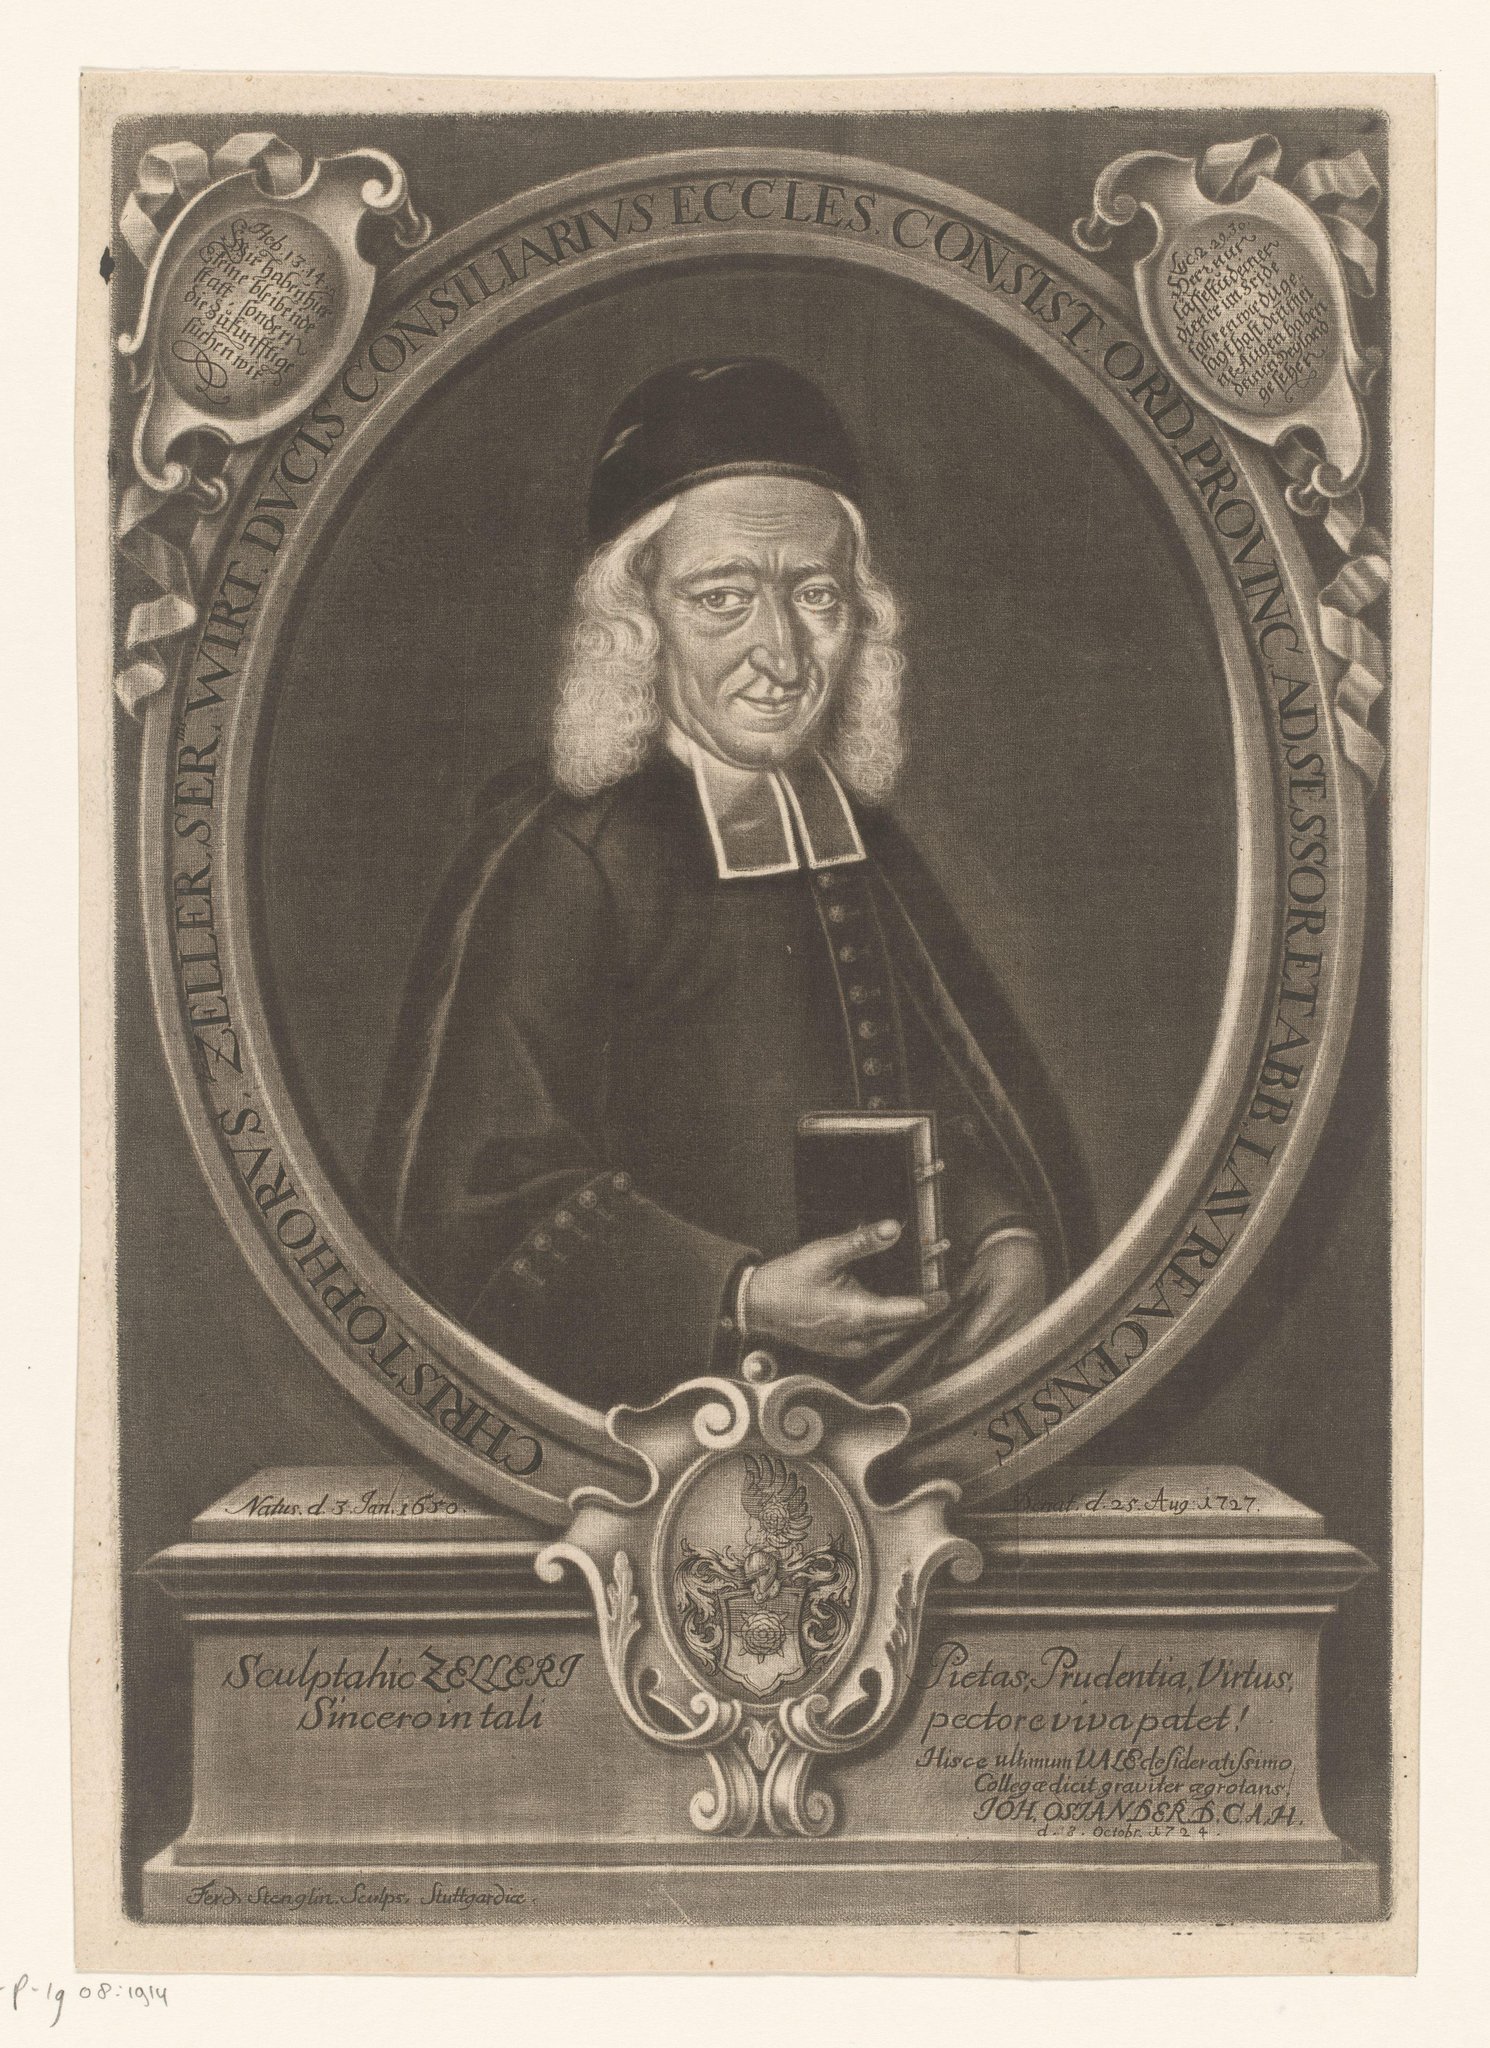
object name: print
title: Portret van Christoph Zeller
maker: ferdinand stenglin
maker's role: print maker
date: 1727-1799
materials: paper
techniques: mezzotint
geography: stuttgart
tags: historical persons, armorial bearing, heraldry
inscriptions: collector's mark: Lugt 2228